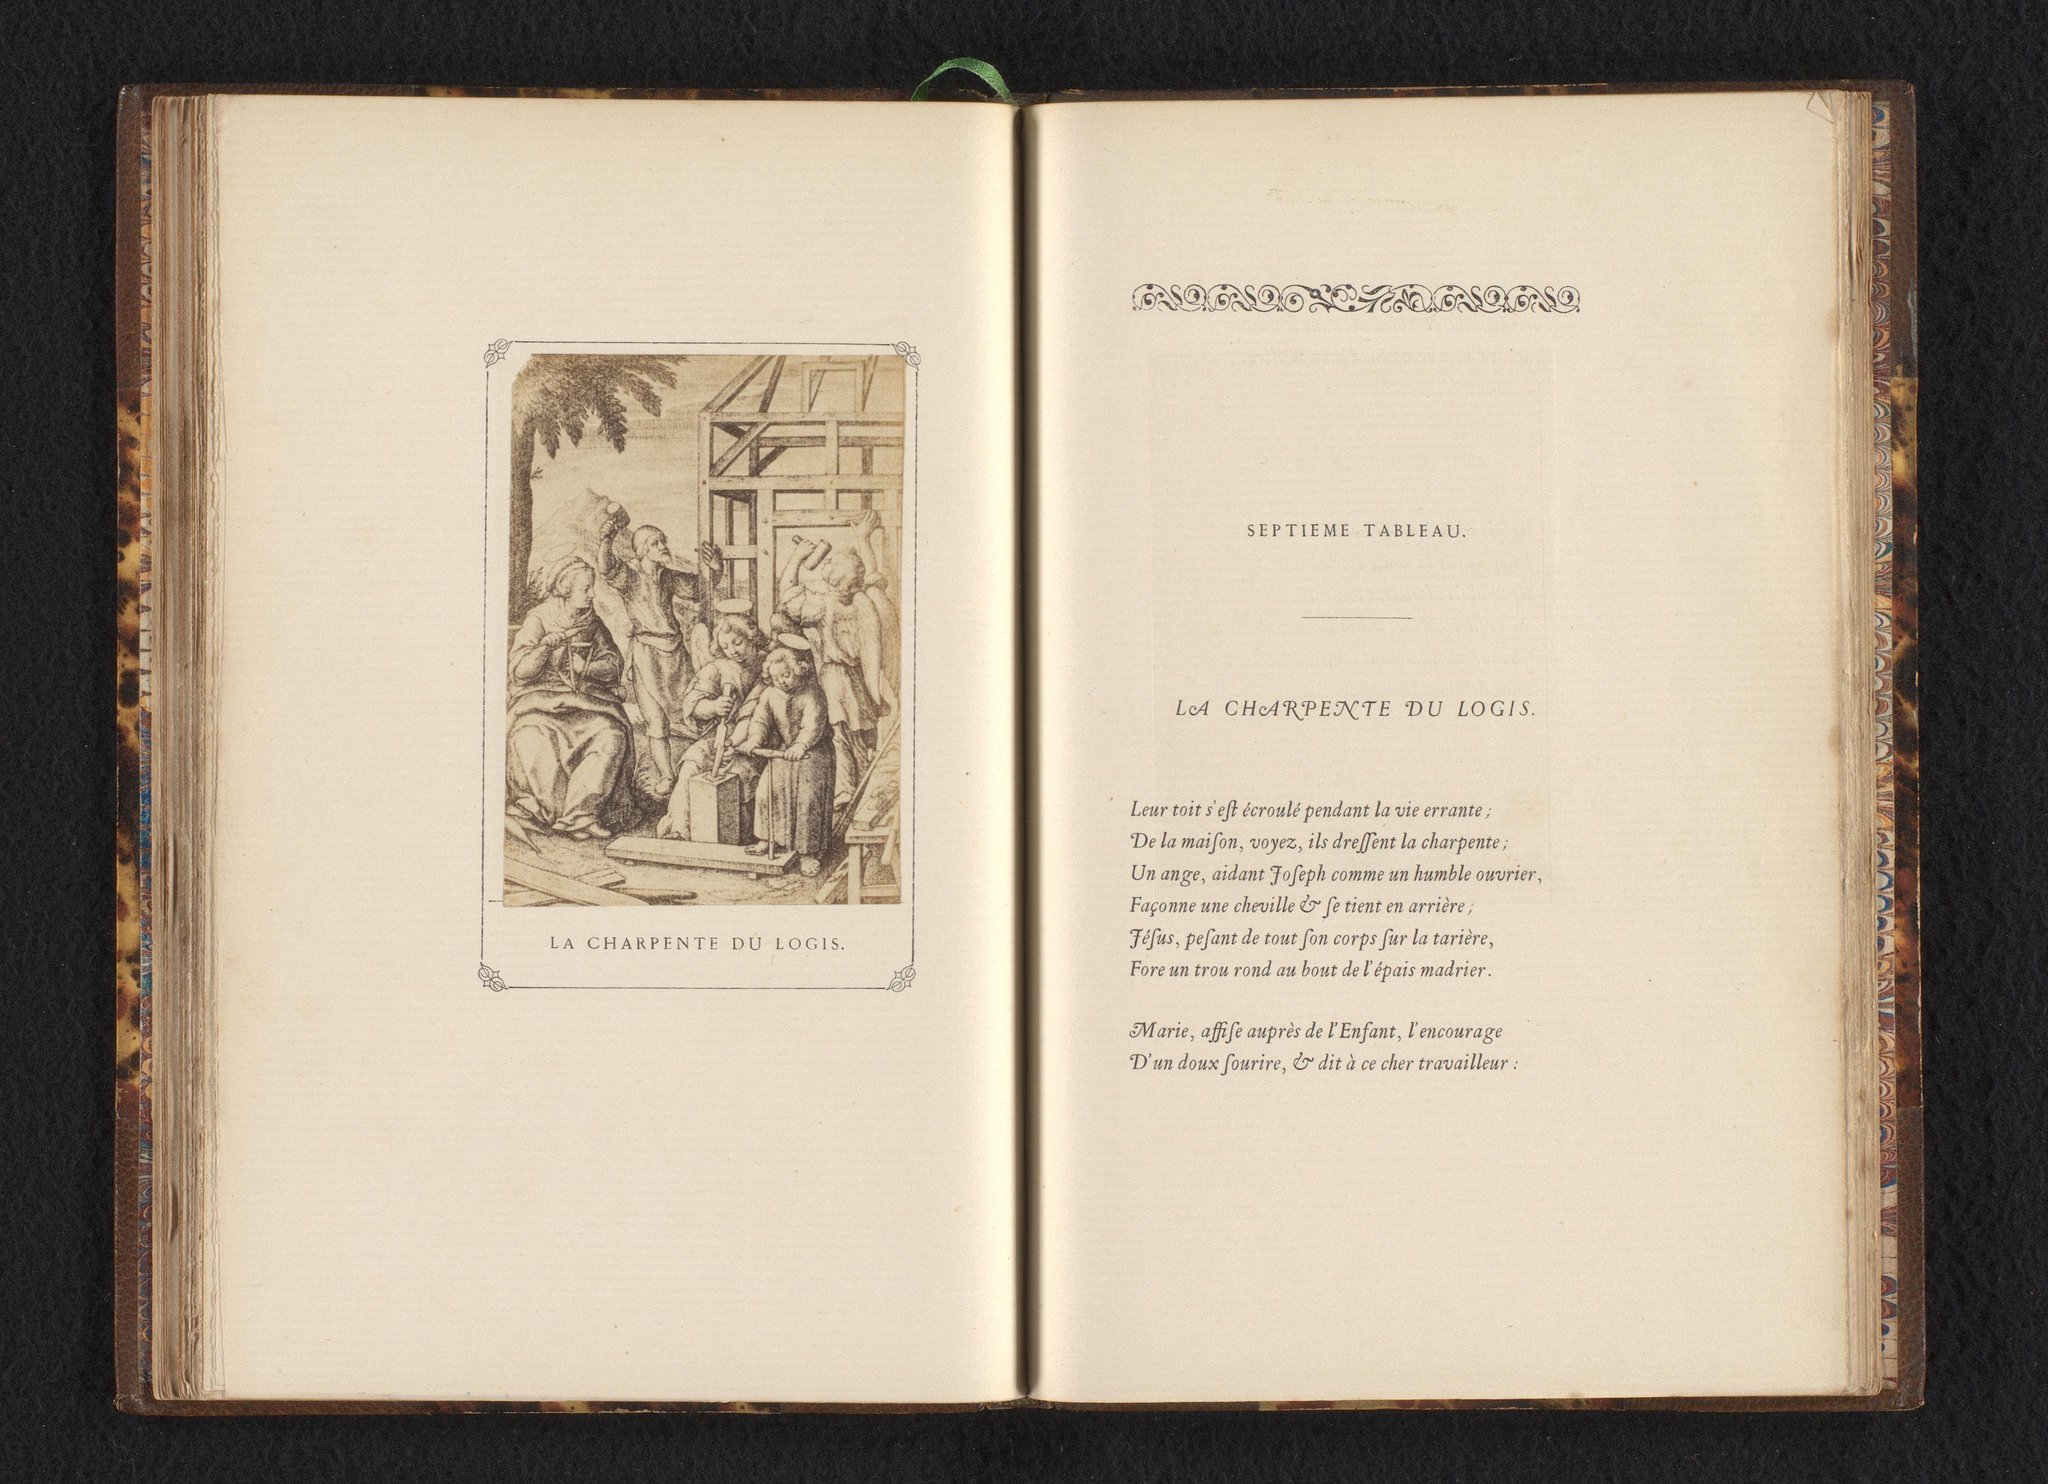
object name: reproduction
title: La charpente du logis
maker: edmond fierlants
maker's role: fotograaf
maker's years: 1819-1869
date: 1855-1860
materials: paper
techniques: albumen print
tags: carpenter, angels